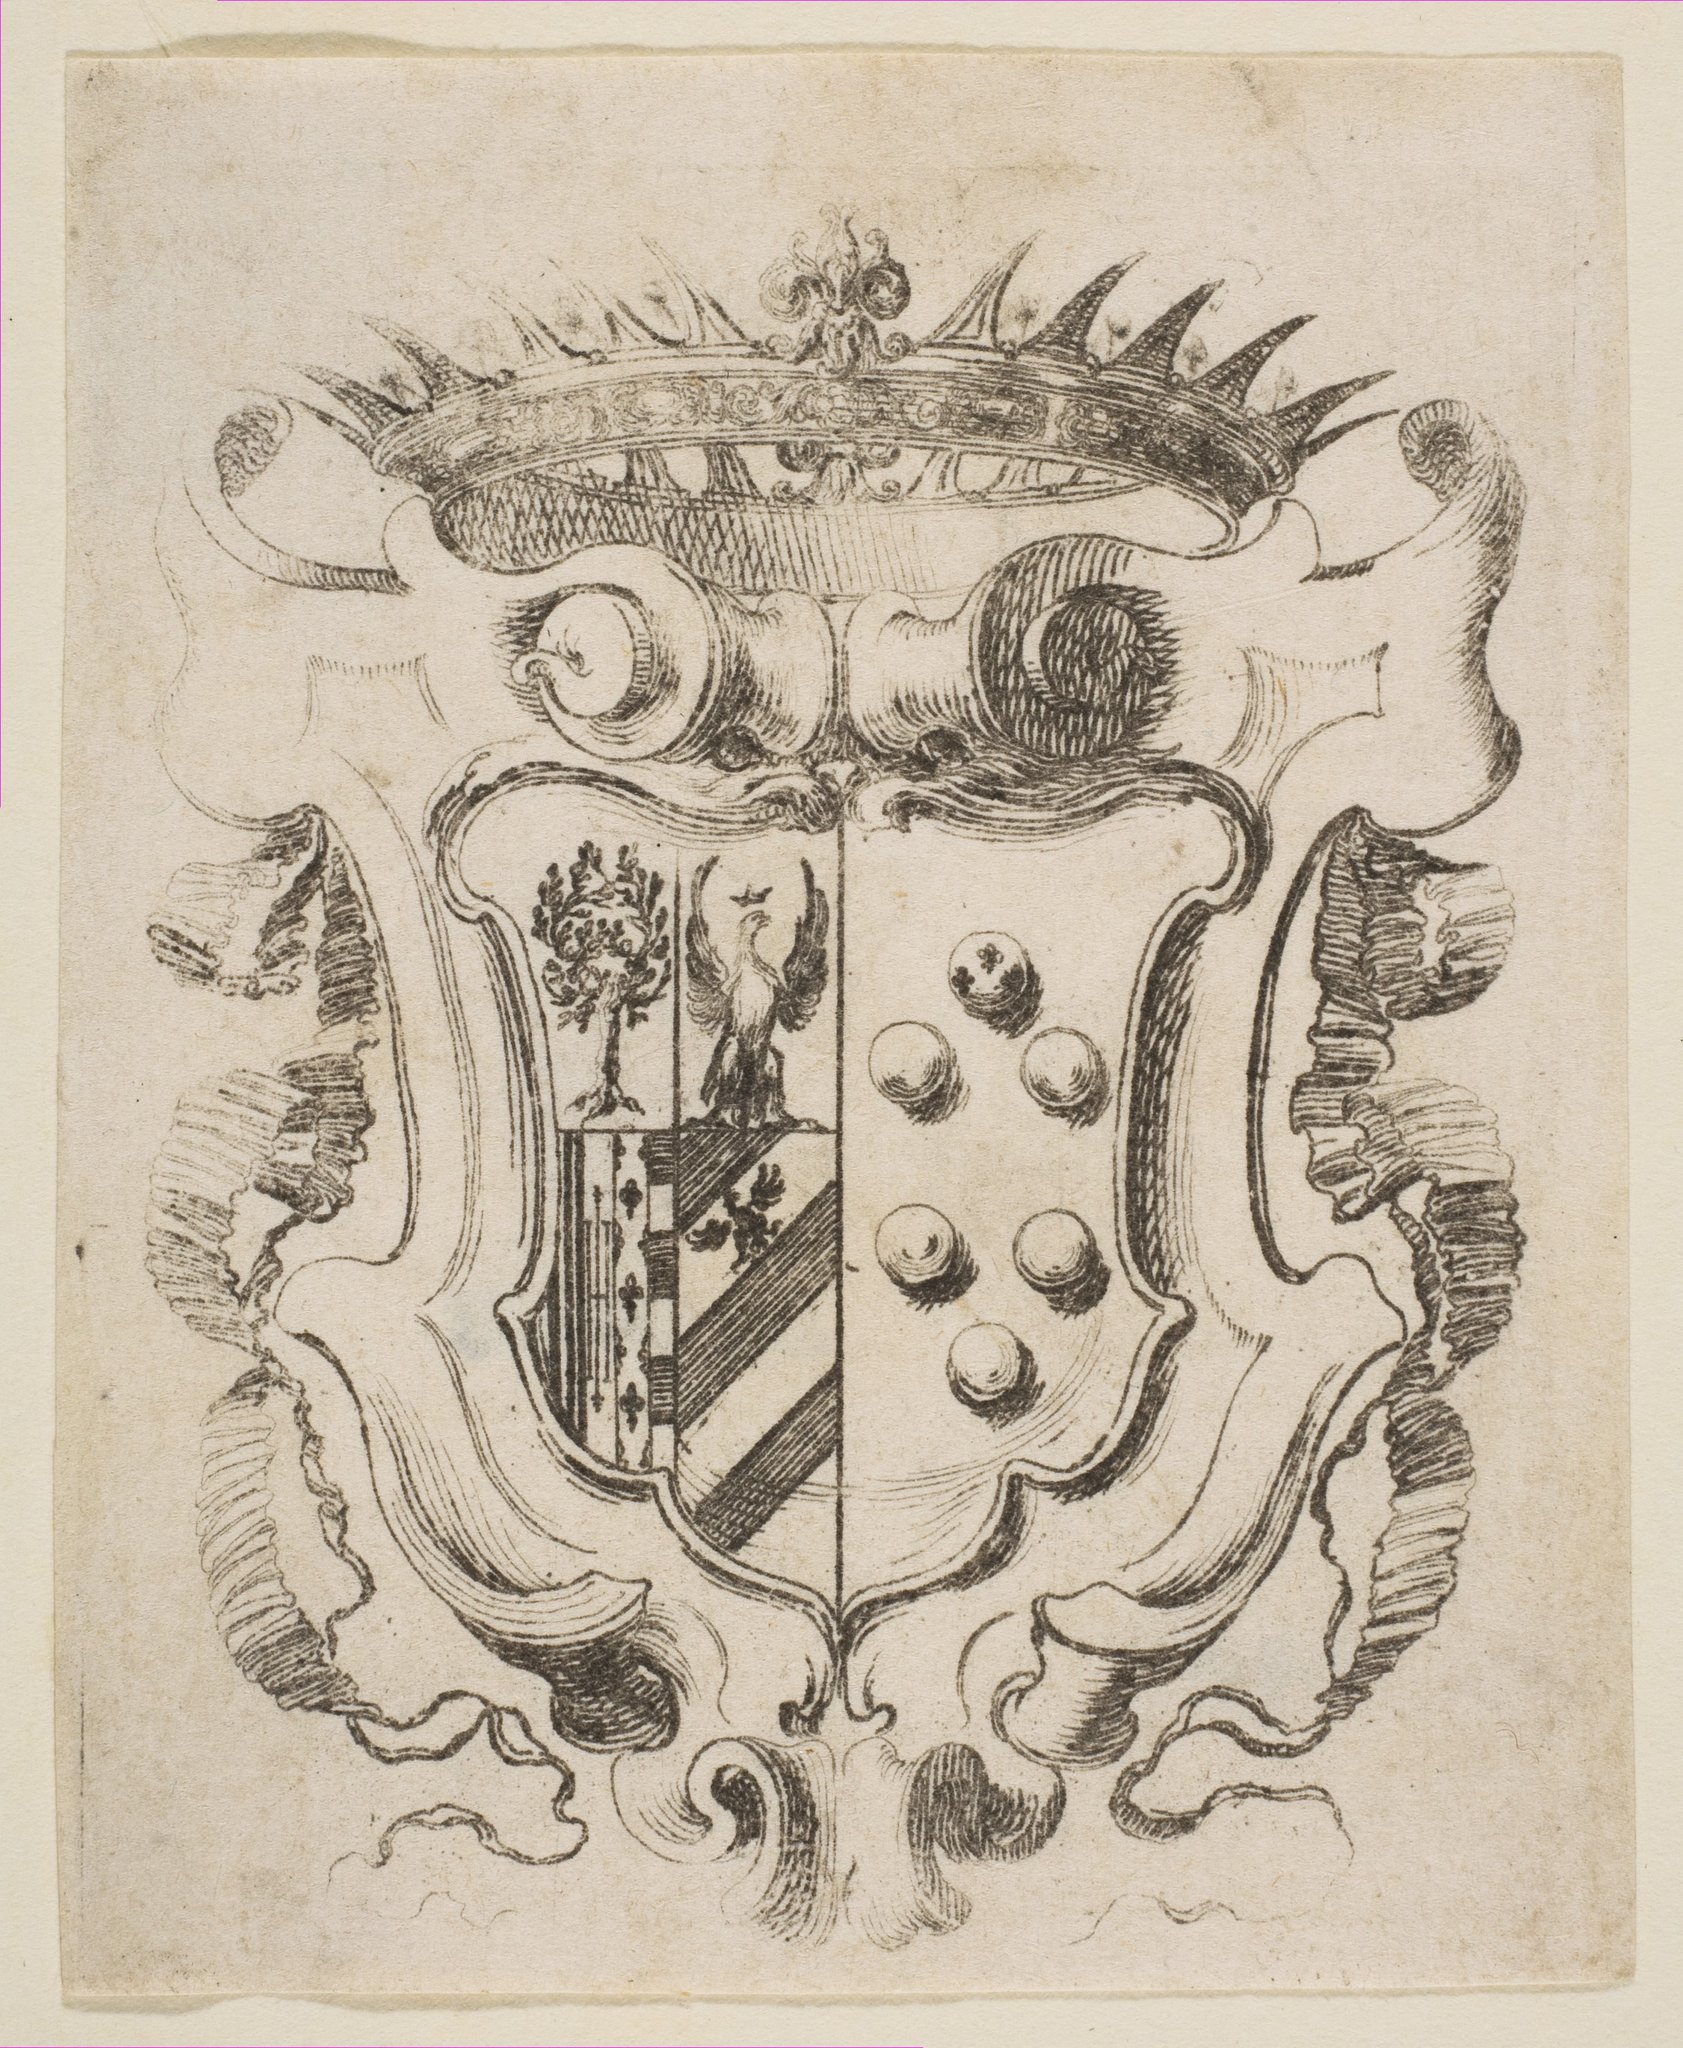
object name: print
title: Arms of the Medici with Della Rovere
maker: stefano della bella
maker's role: artist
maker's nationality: italian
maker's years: 1610-1664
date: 1637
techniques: etching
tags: coat of arms